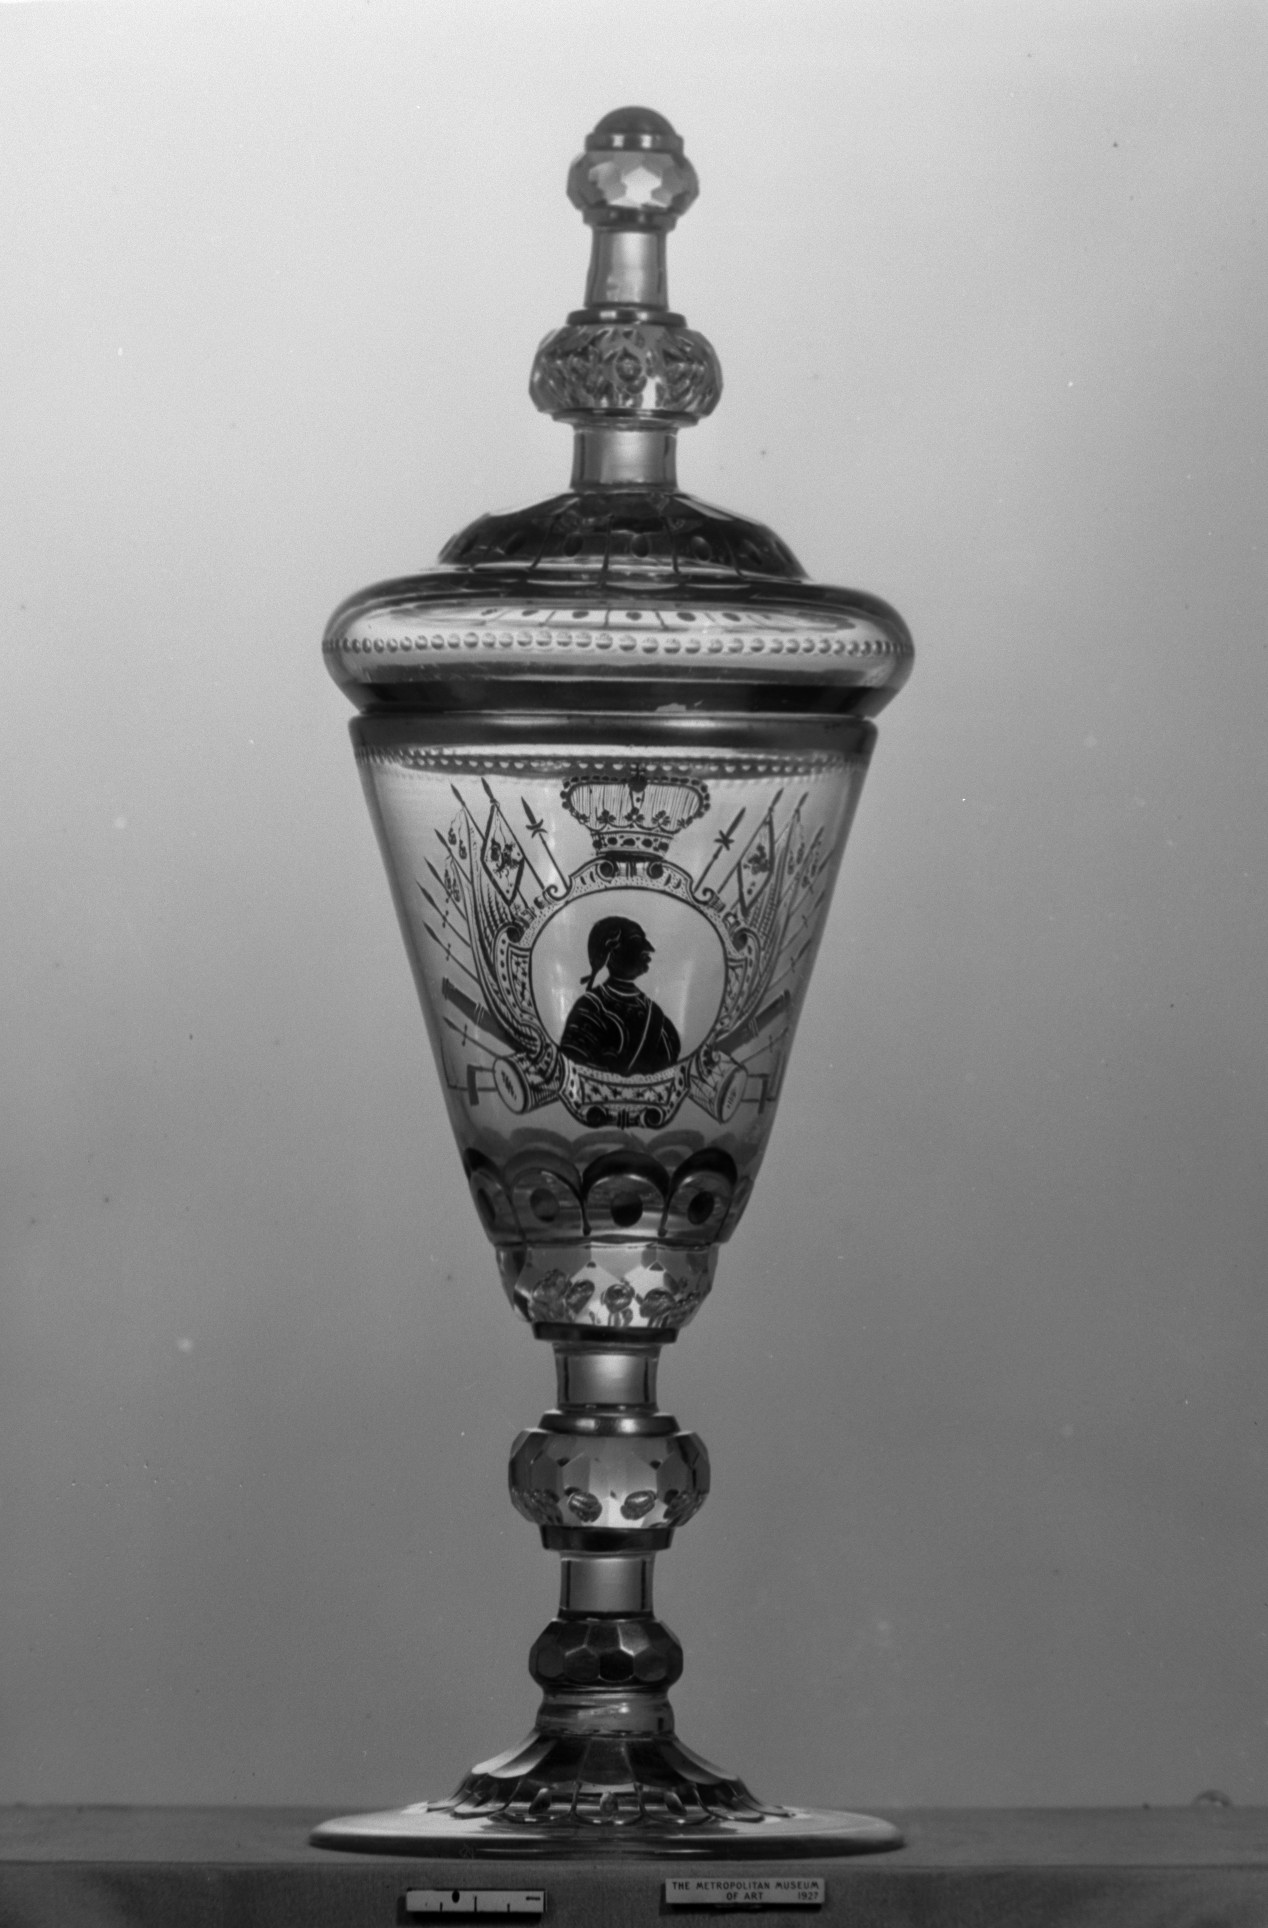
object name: standing cup with cover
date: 1730-1750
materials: glass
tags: men,profiles